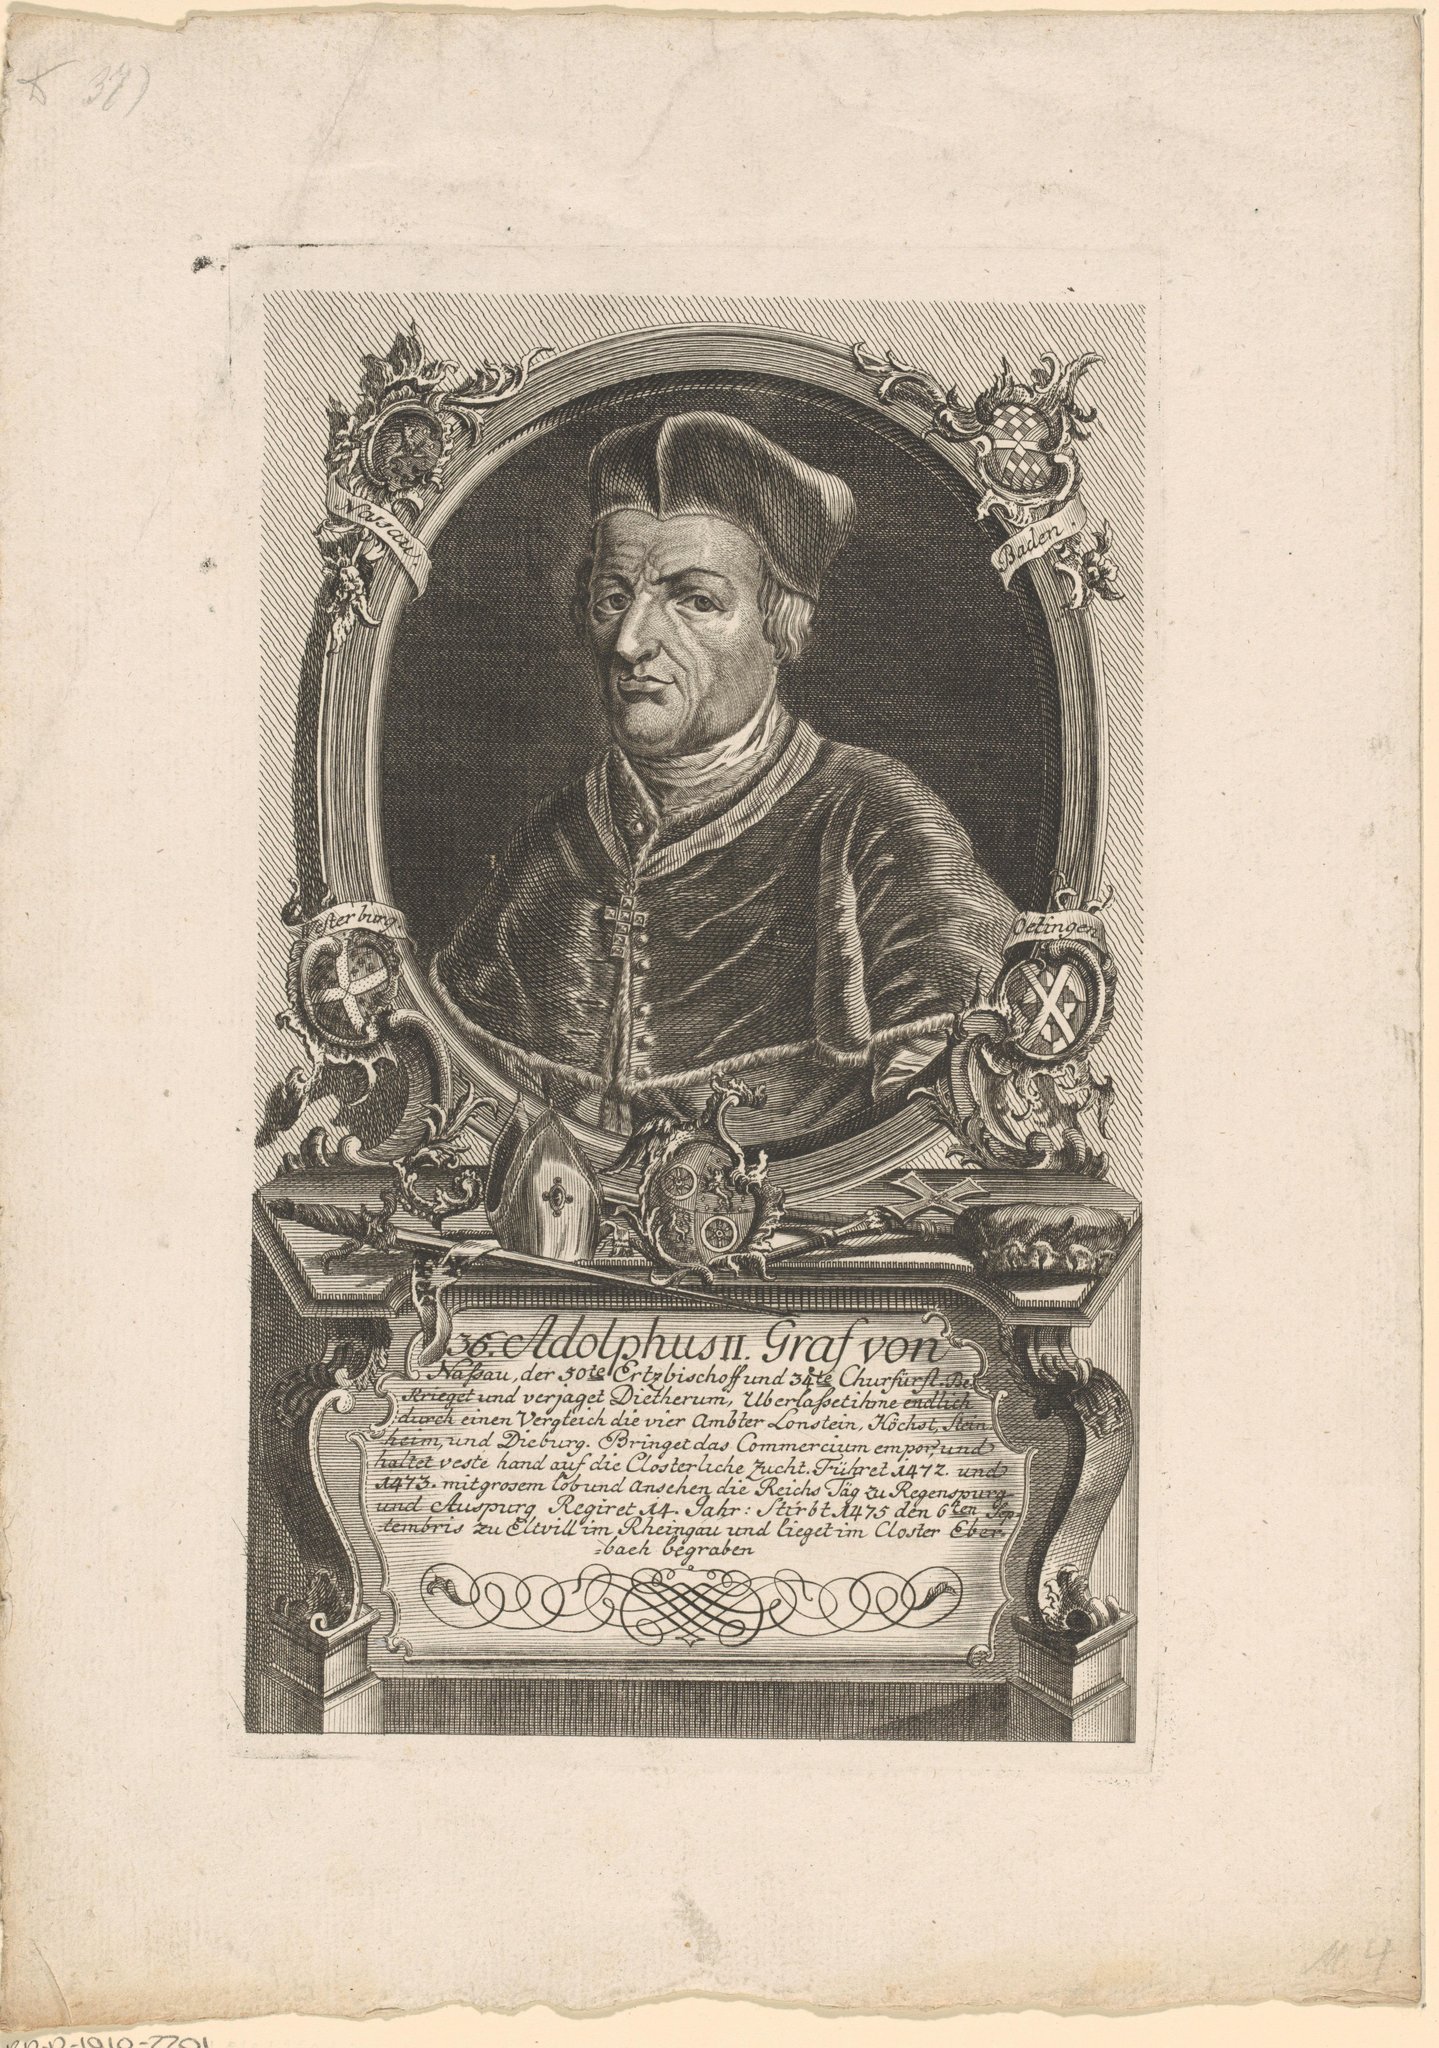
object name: print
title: Portret van Adolf II van Nassau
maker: Anonymous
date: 1600-1699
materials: paper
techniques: engraving, etching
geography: germany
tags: adolf ii van nassau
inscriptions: collector's mark: Lugt 2228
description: Portret van Adolf II in een ovaal. Daar omheen een aantal allegorische objecten. Rondom een aantal wapens. Op een voetstuk tien regels Duitse tekst.